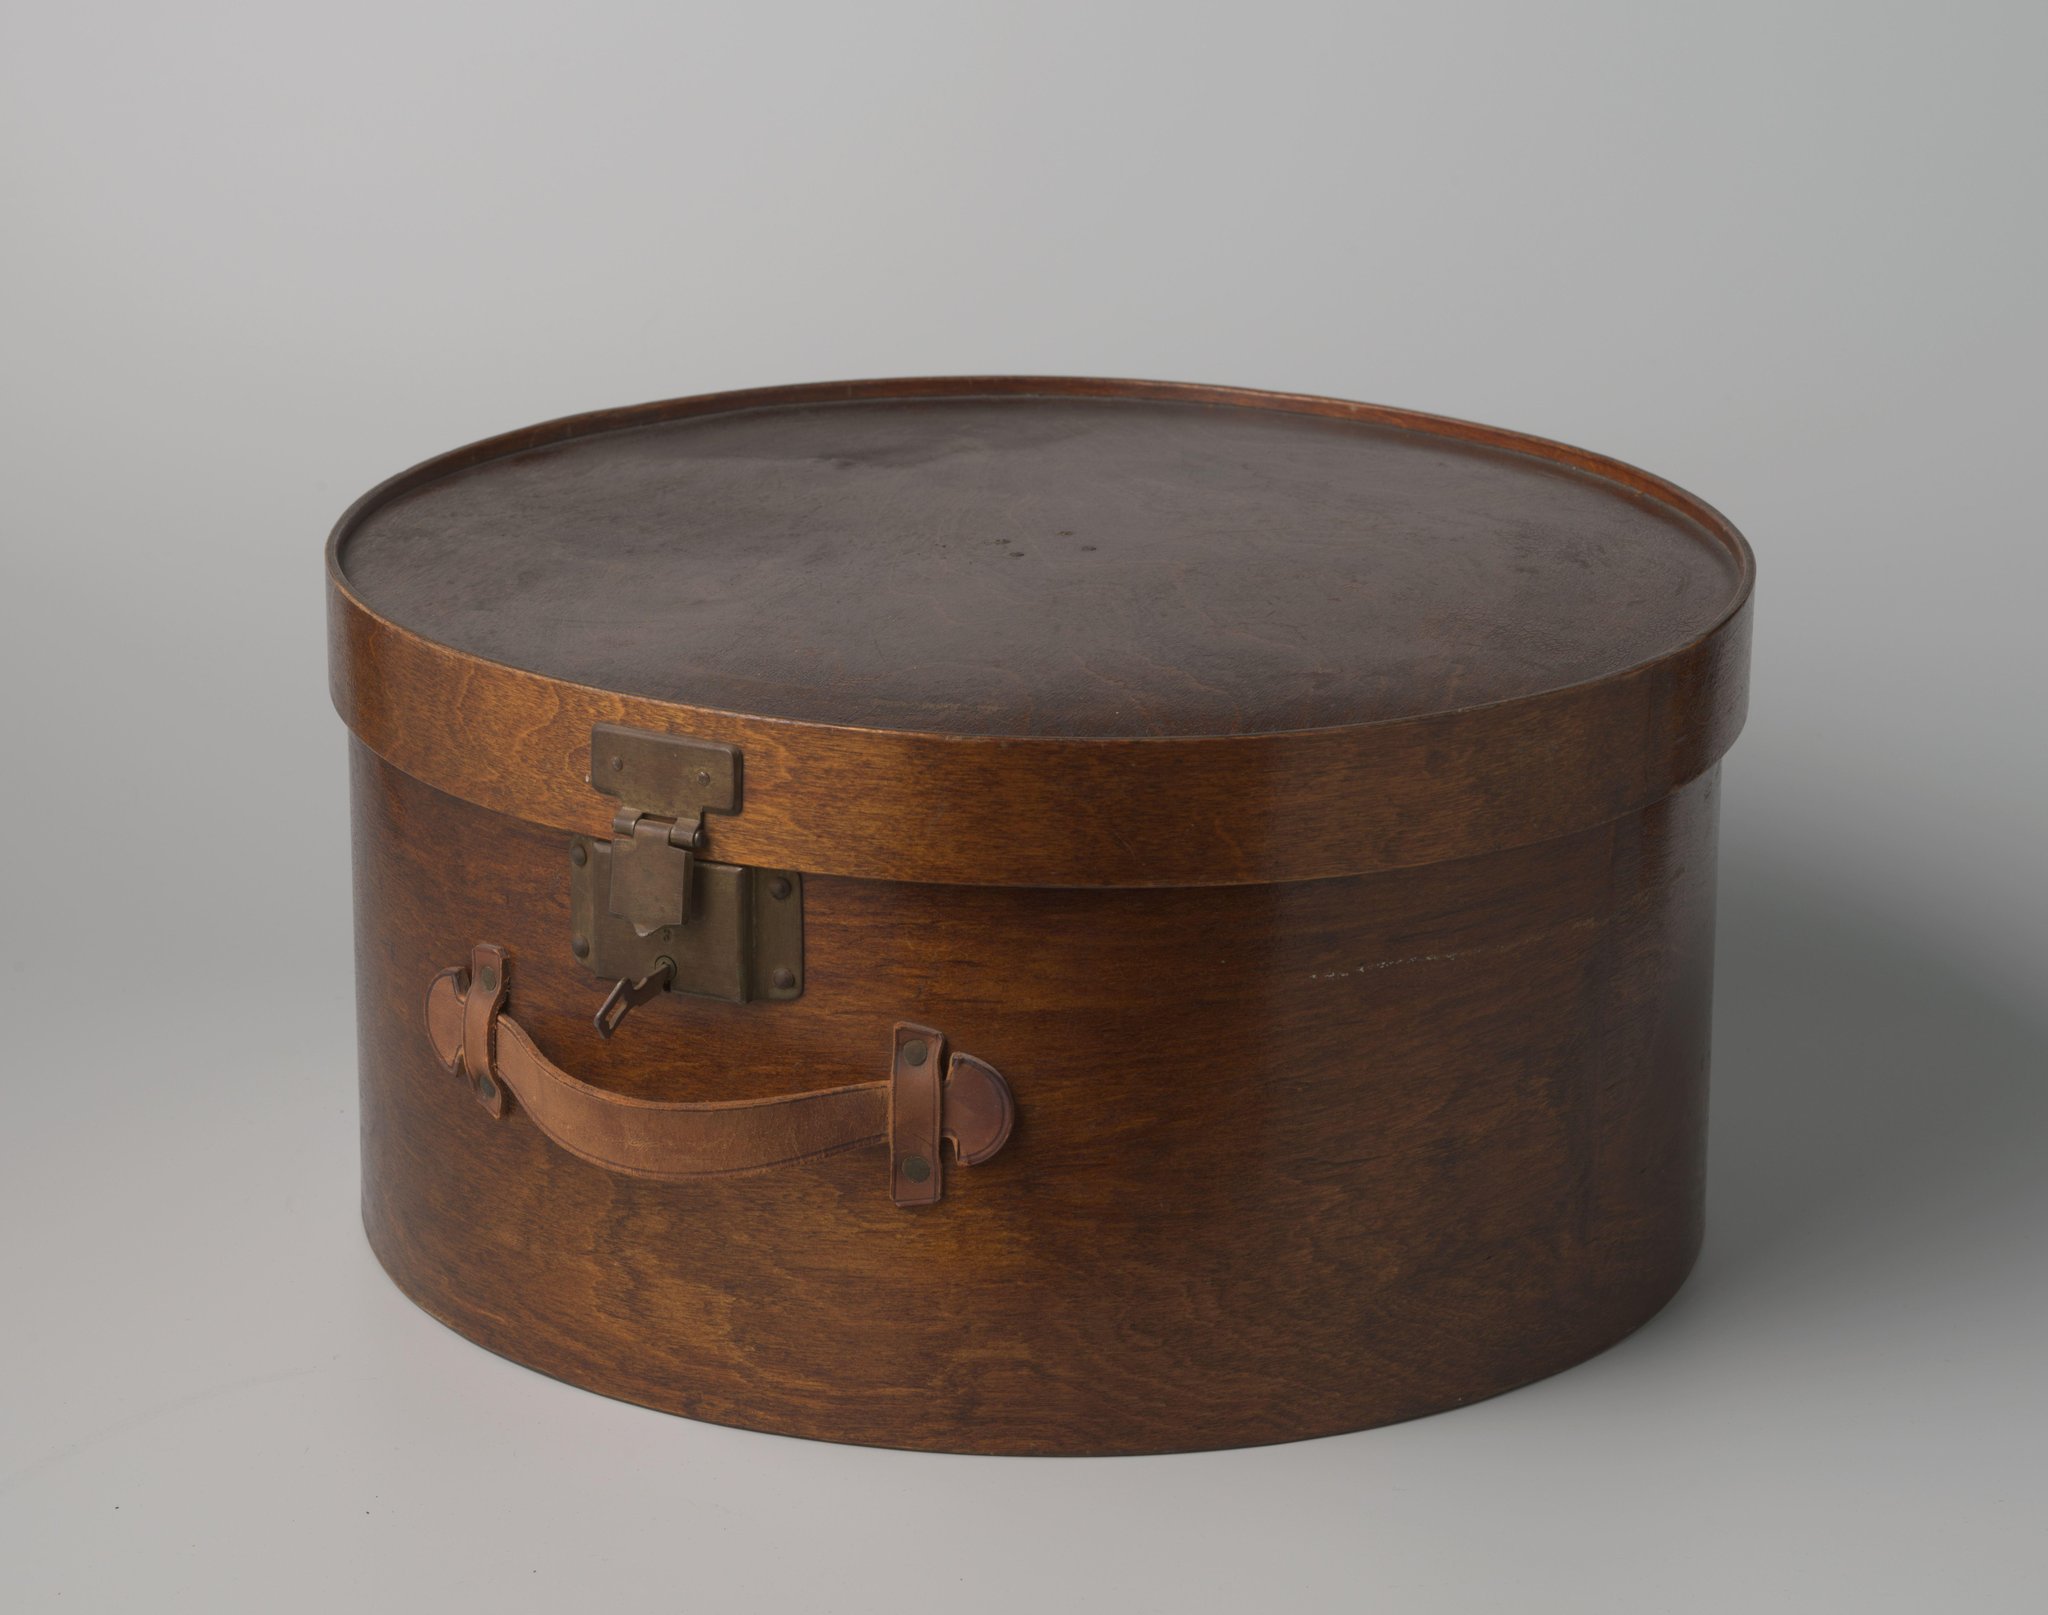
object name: hoedenkoffer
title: Ronde hoedenkoffer, bruin, van gelakt hout met een slot van koper en een handvat van leer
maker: Anonymous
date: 1940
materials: copper, leather, linen, wood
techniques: lacquer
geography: netherlands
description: Dameshoed, rouwhoed in een ronde, bruin kouten hodenkoffer. Materiaal: gevlochten, breed kunstraffia, glimmend gelakt. Model: flambard, met hoge bol, met ringplooi. Iets afhangende rand. Breed ripslint.